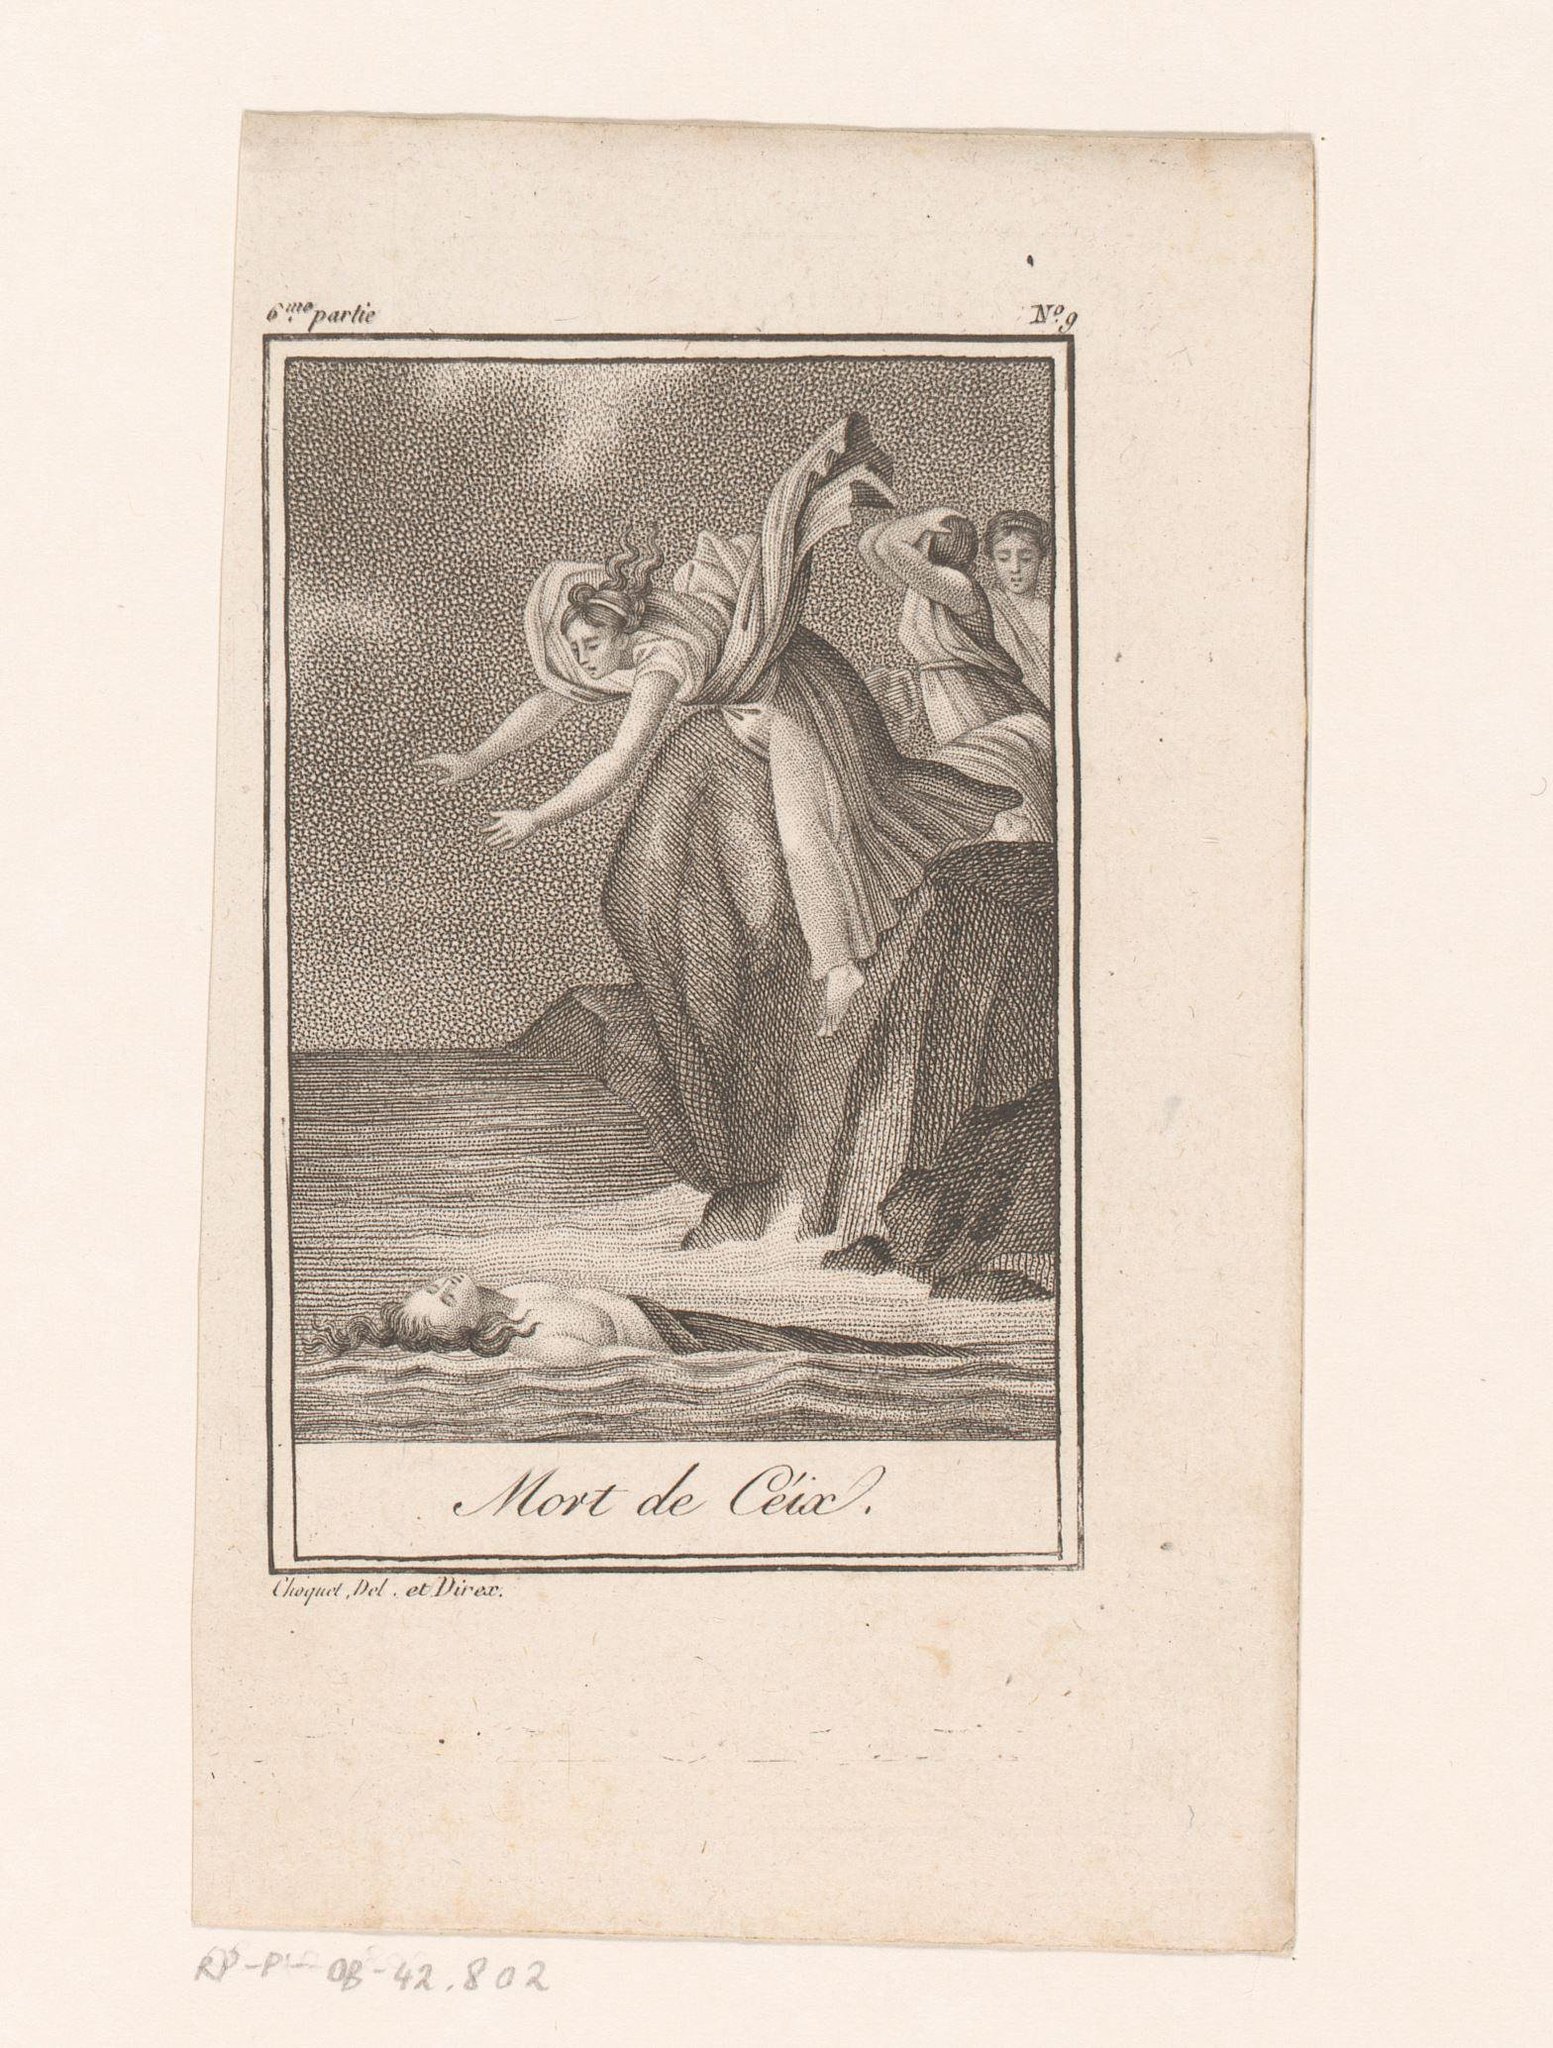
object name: print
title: Mythologische scènes onder supervisie van Choquet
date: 1784-1824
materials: paper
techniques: engraving, etching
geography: france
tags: ceyx shipwrecked and drowned at sea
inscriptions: collector's mark: Lugt 2228